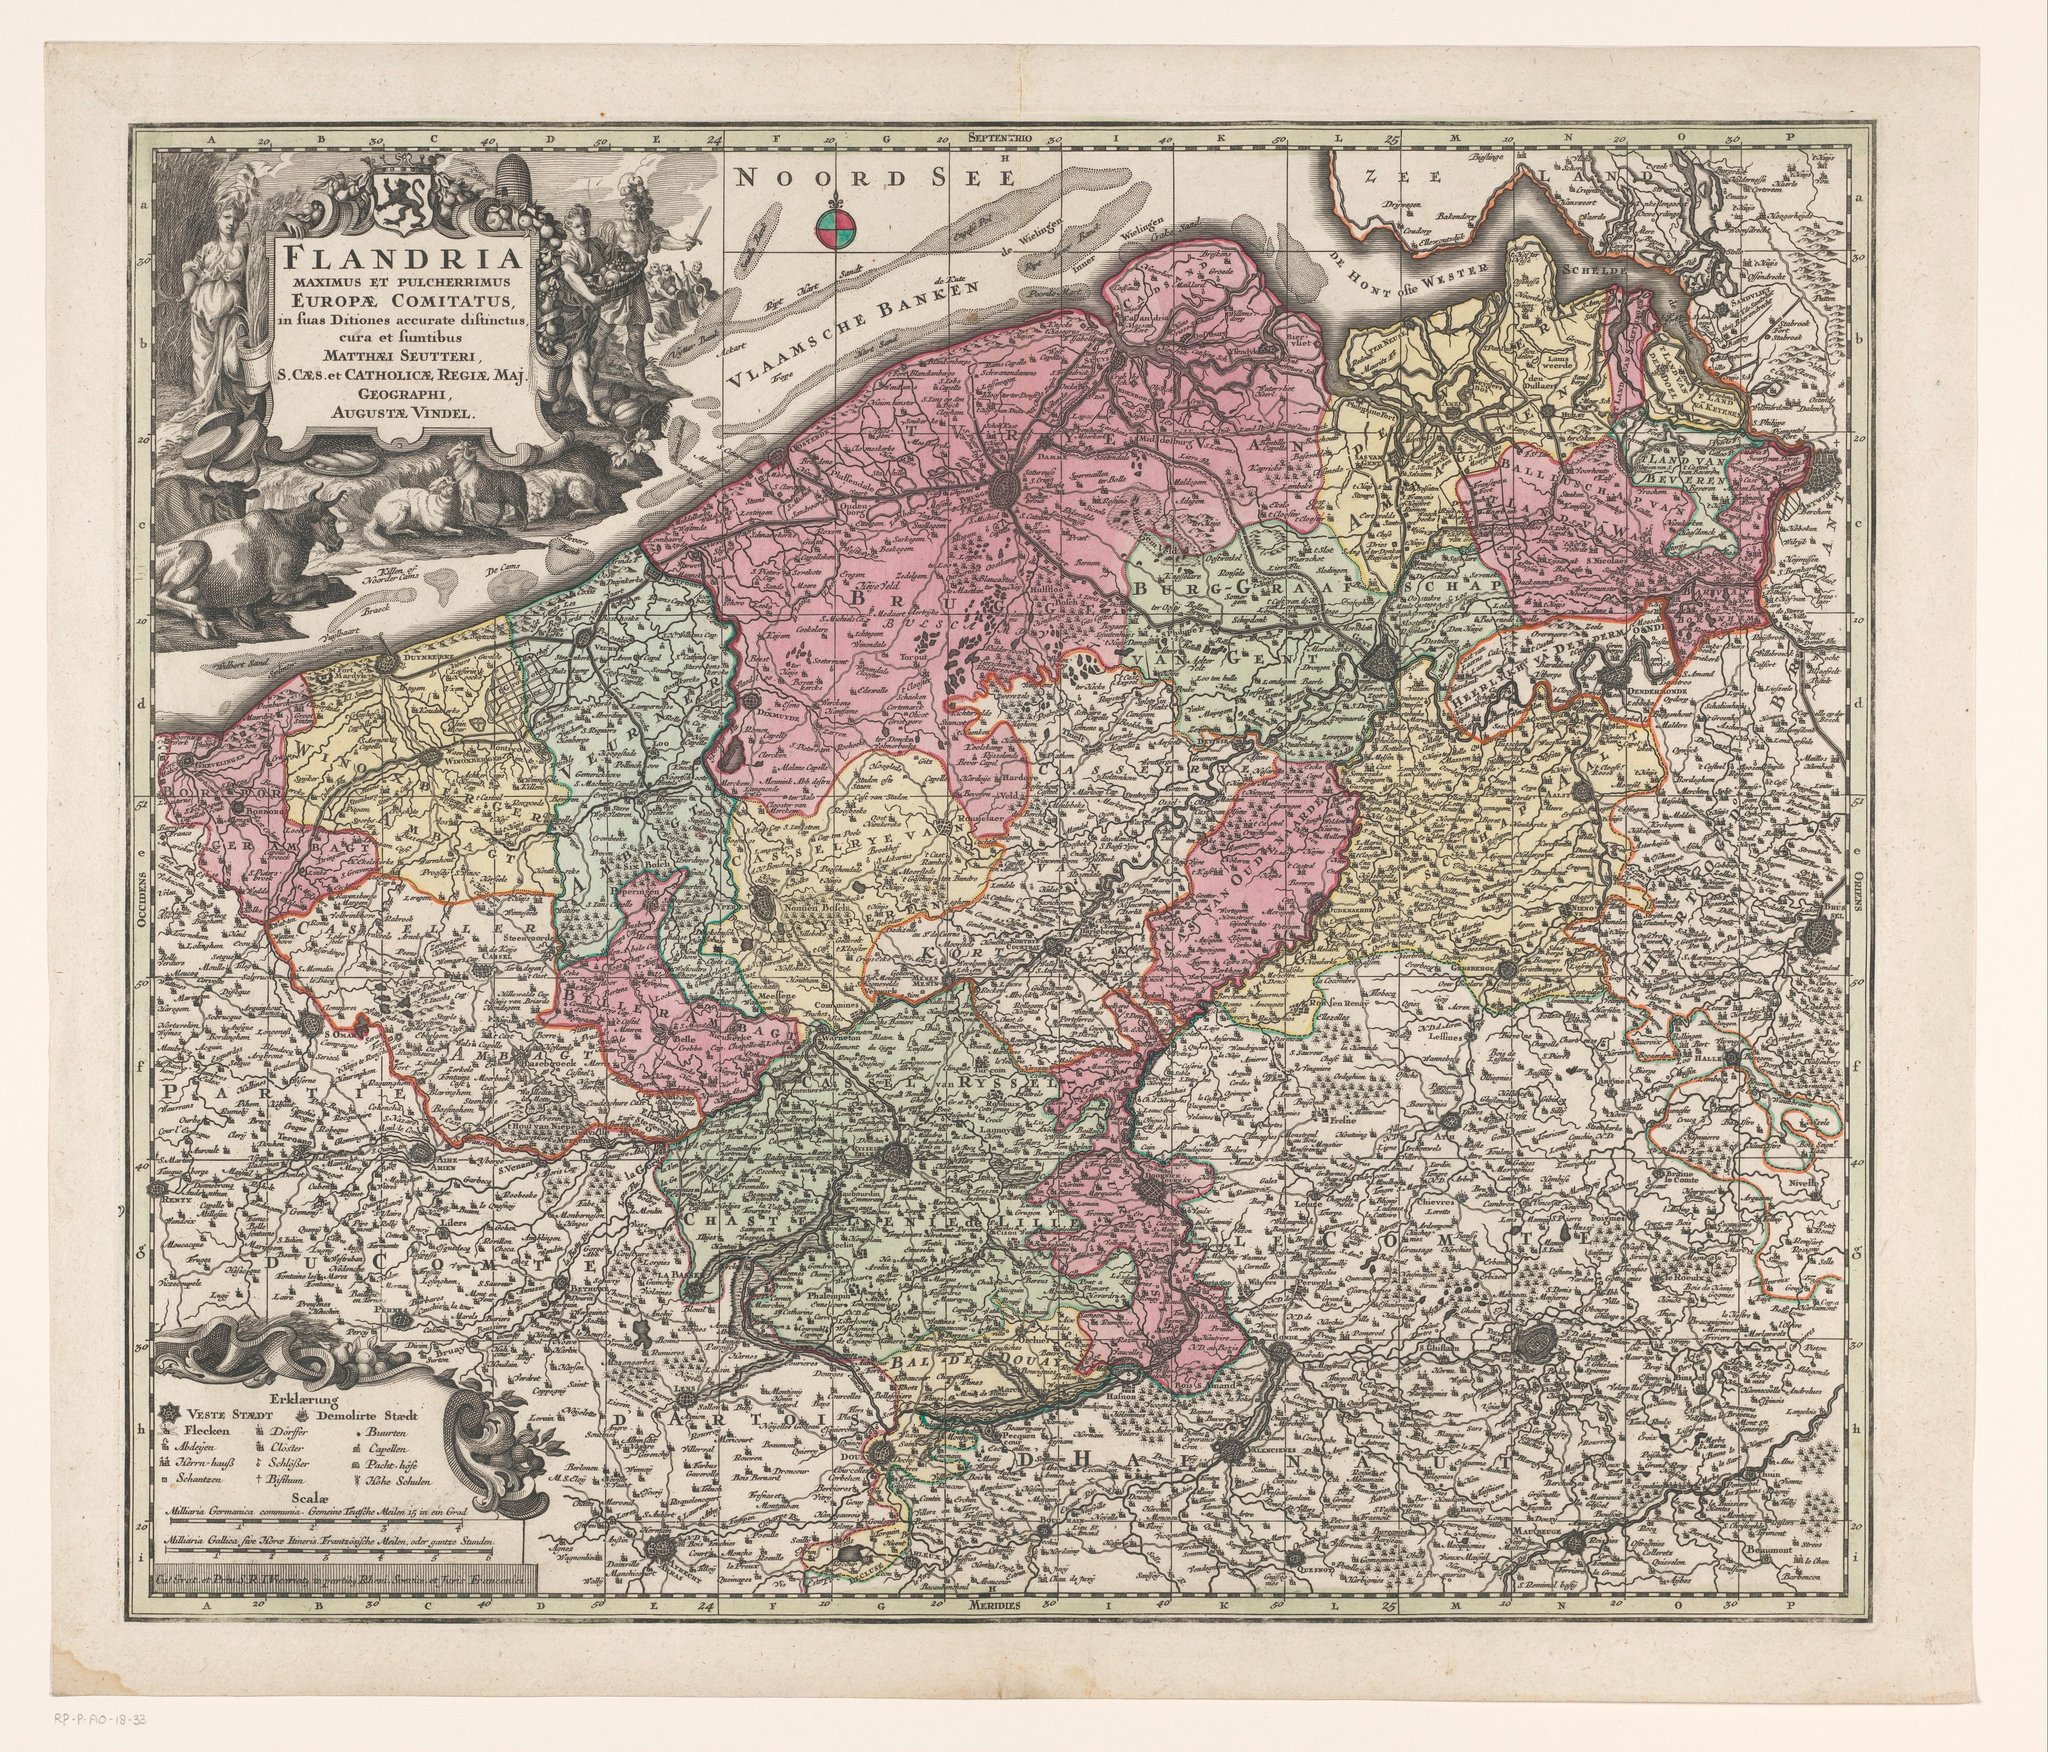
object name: print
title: Flandria maximus et pulcherrimus Europae comitatus (...)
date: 1707-1757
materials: paper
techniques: engraving, etching, hand coloring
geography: augsburg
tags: cow, maps of separate countries or regions, sheep, bee-hive, cereal, grain, corn (grass with grains, grown for food, e.g.: wheat, rice, rye, oats, maize, buckwheat, millet), coat of arms (as symbol of the state, etc.) (+ province; provincial), cheese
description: Kaart van het graafschap Vlaanderen. Linksboven de titelcartouche met daaromheen schapen, koeien, koren en andere symbolen voor vruchtbaarheid. Bovenin het cartouche het wapen van het graafschap Vlaanderen. Linksonder een cartouche met legenda en twee schaalstokken: 4 Milliaria Germanica communia / 6 Milliaria Gallica sive Horae Itineris. De kaart is voorzien van een zoekrooster en gradenverdeling langs de randen.